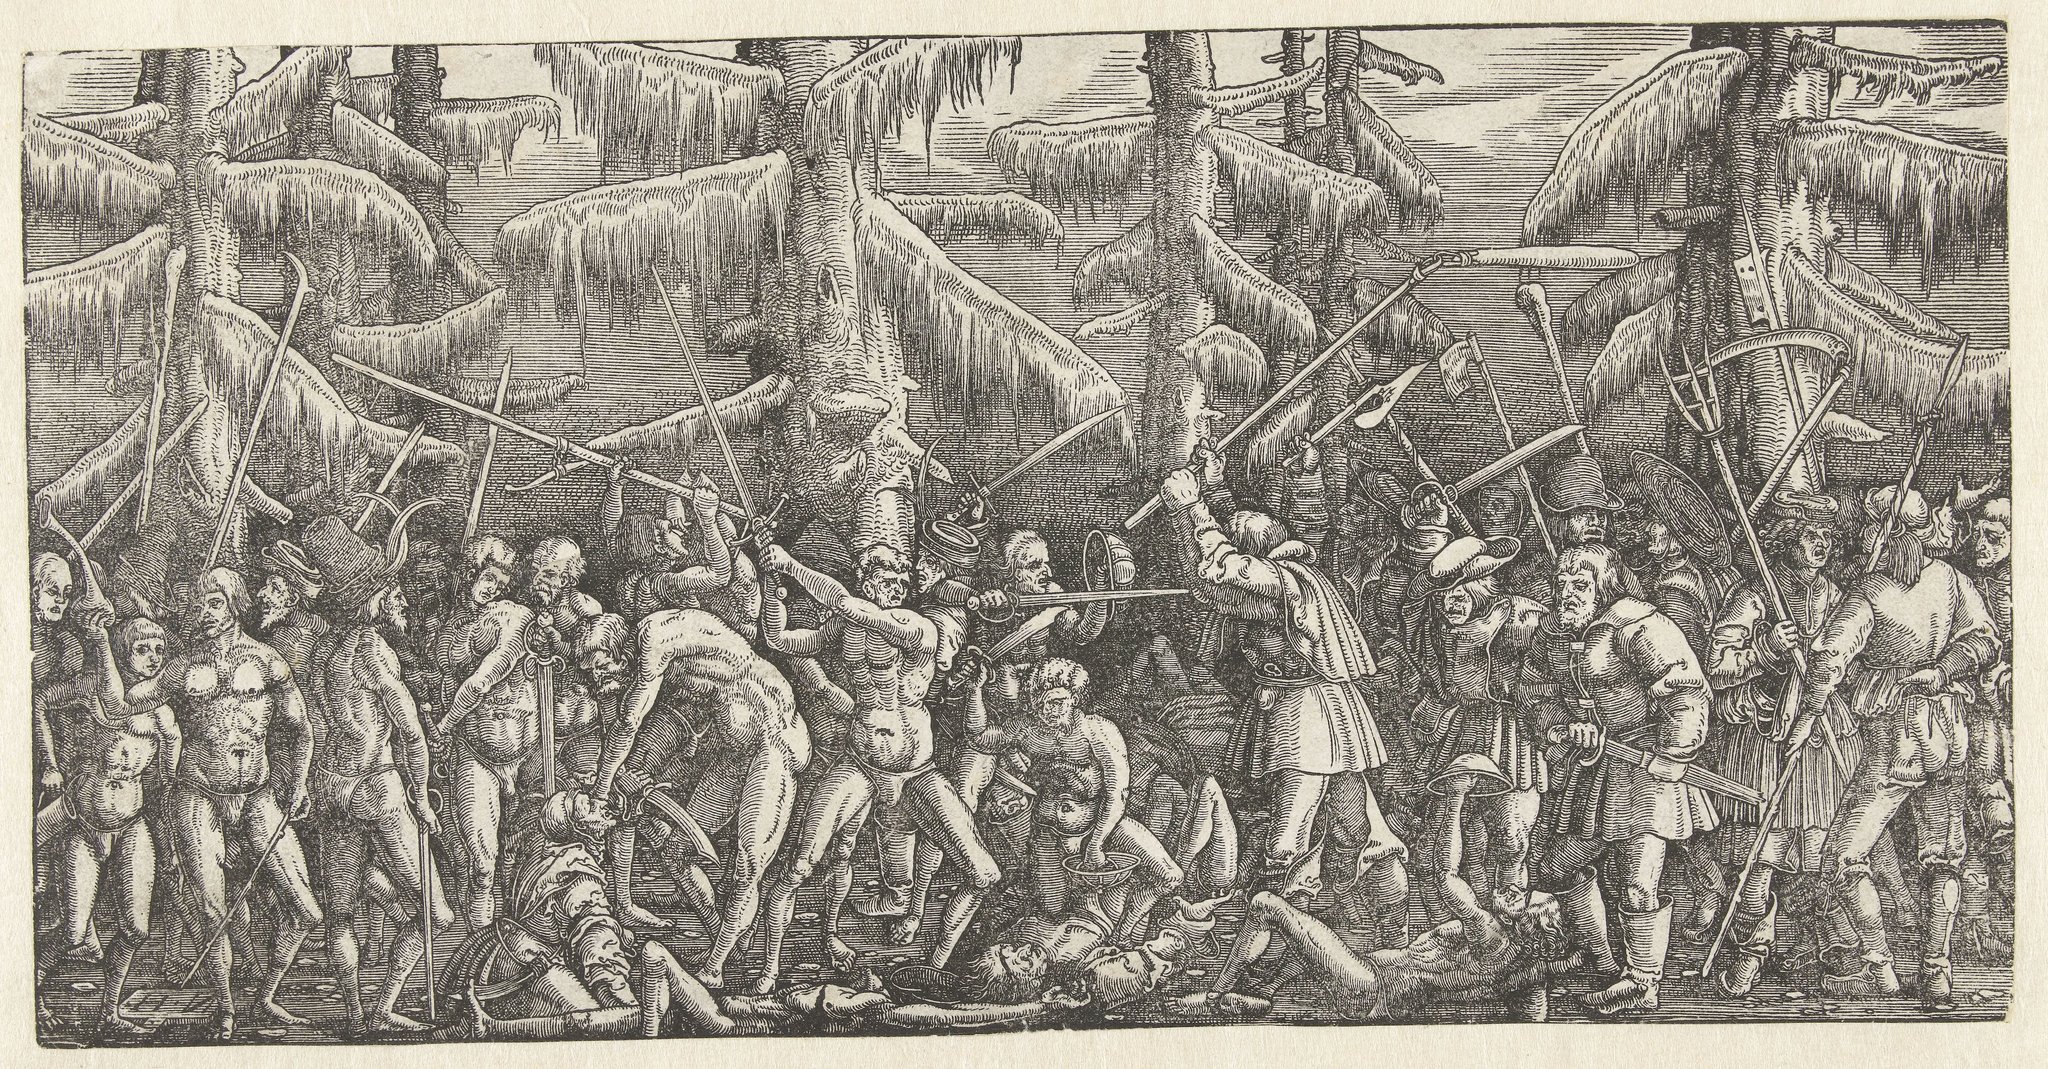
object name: print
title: Strijd van naakte mannen en boeren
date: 1522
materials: paper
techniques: woodcut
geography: germany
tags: fight between farmers and soldiers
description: Monogrammist NH wordt vaak vereenzelvigd met Nikolaus Hogenberg maar er zijn nog veel onduidelijkheden rond deze kunstenaar (zie documentatie). Hollstein beschrijft verschillende staten en noemt daarnaast ook de versie waarbij de tekst onder de prent geheel ontbreekt maar geeft die staat geen nummer.